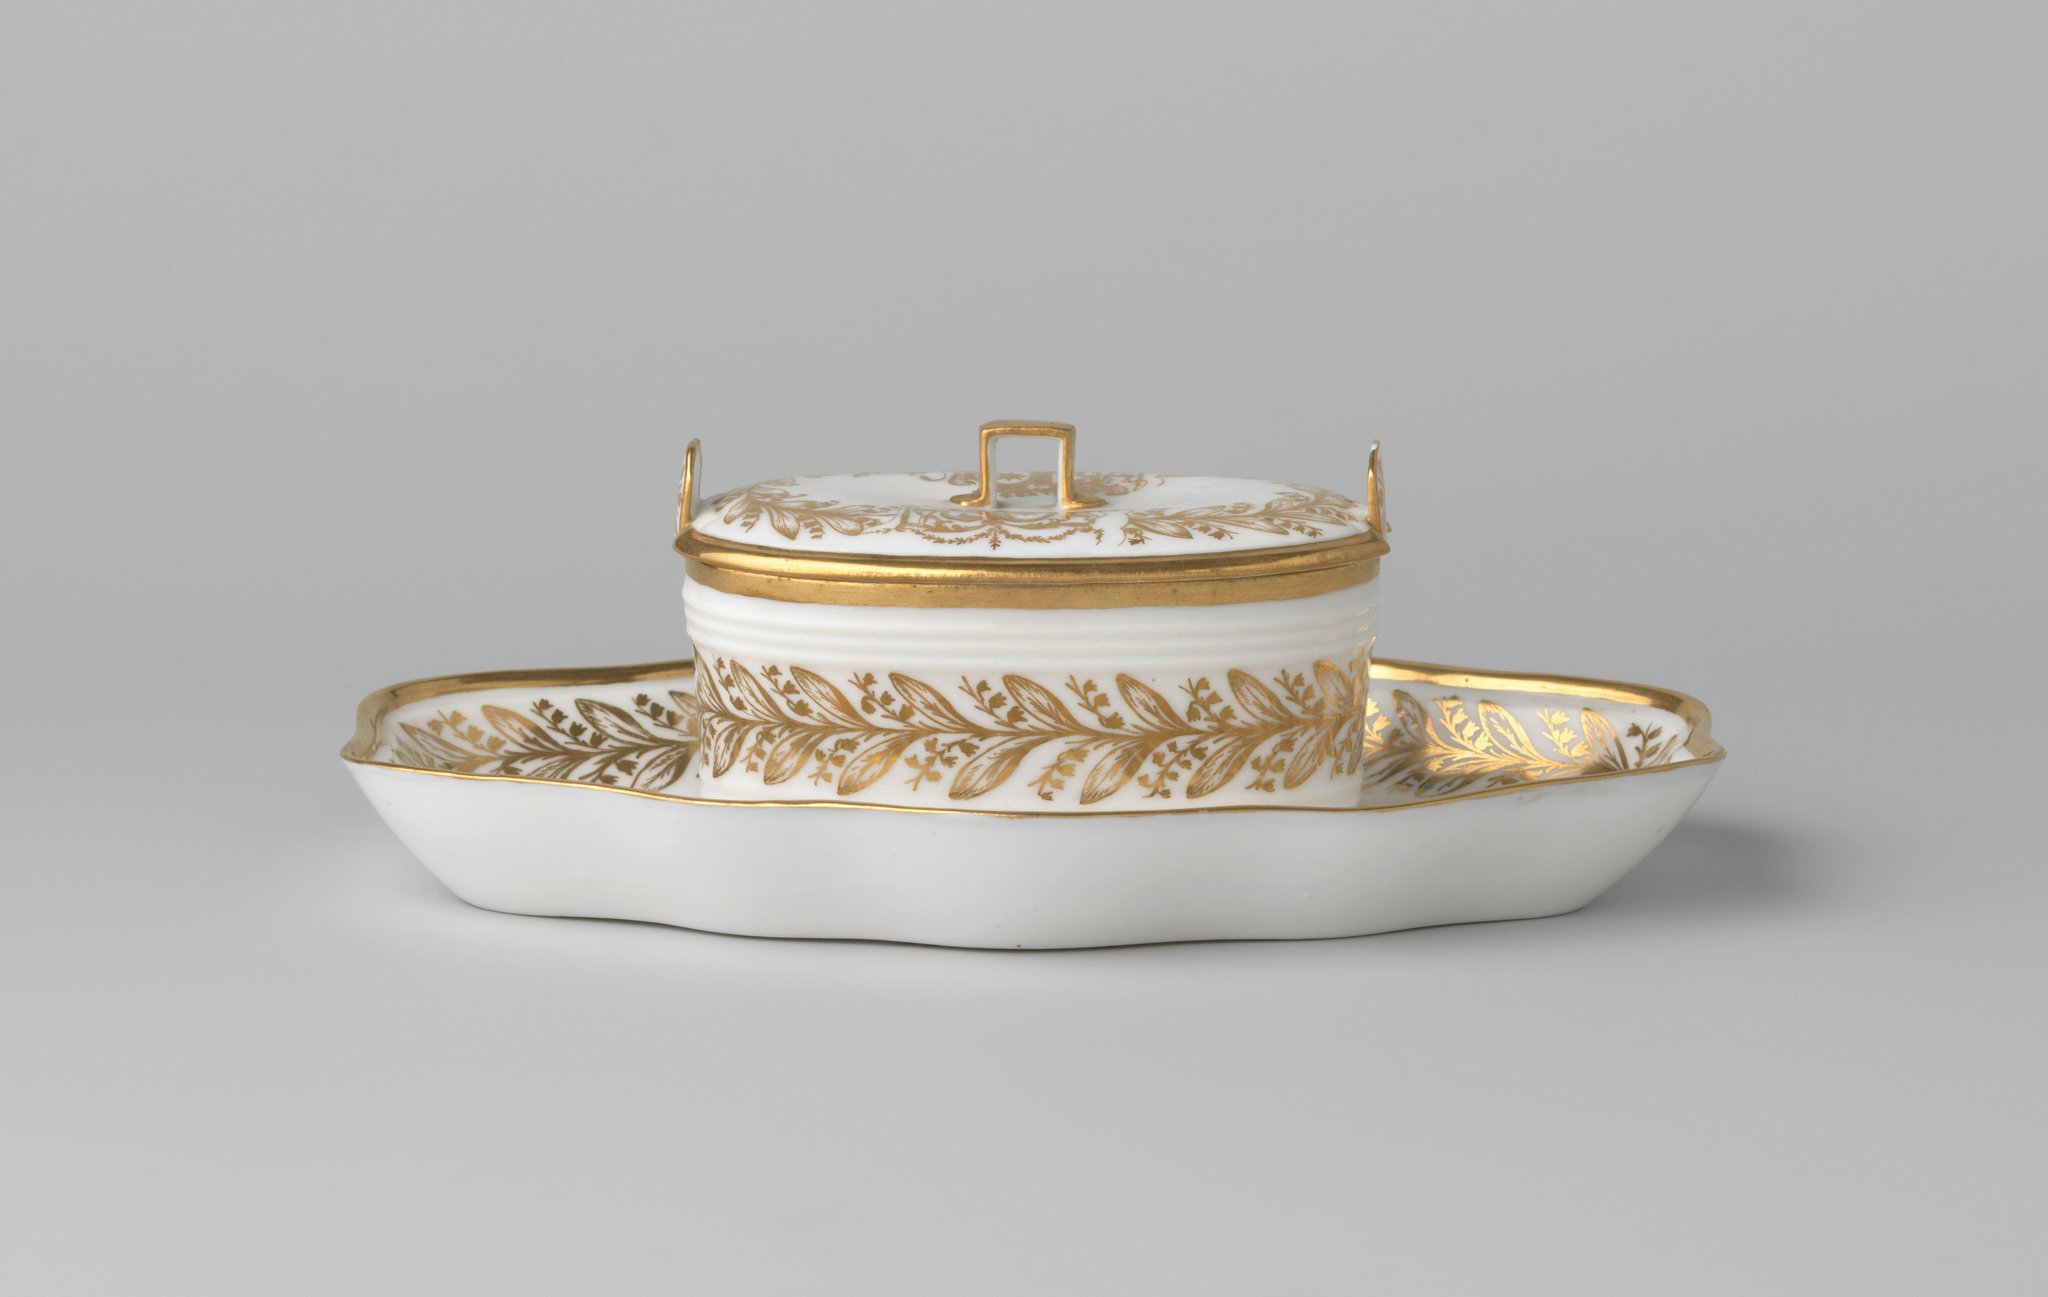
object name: butter dish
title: Butter tub with the coat of arms of Hendrik Peter Godfried Quack and Isabella Gertraud von Carnap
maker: Anonymous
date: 1790-1800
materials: glaze, gold, paint, porcelain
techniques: firing, forming, gilding, turning, vitrification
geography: paris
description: Botervloot van porselein op een vaste onderschotel, beschilderd op het glazuur met goud. Zowel de vloot als de schotel is ovaal, waarbij de schotel een gelobde wand heeft. Op de buitenwand van de vloot en de binnenwand van de schaal een bloemrank. De deksel met een vierkant handvat en aan de zijkanten een opstaand deel met een gat. Versierd met het alliantiewapen van Hendrik Peter Godfried Quack en Isabella Gertraud von Carnap en een bloemrank. Gouden banden op de randen. Geen voetring.